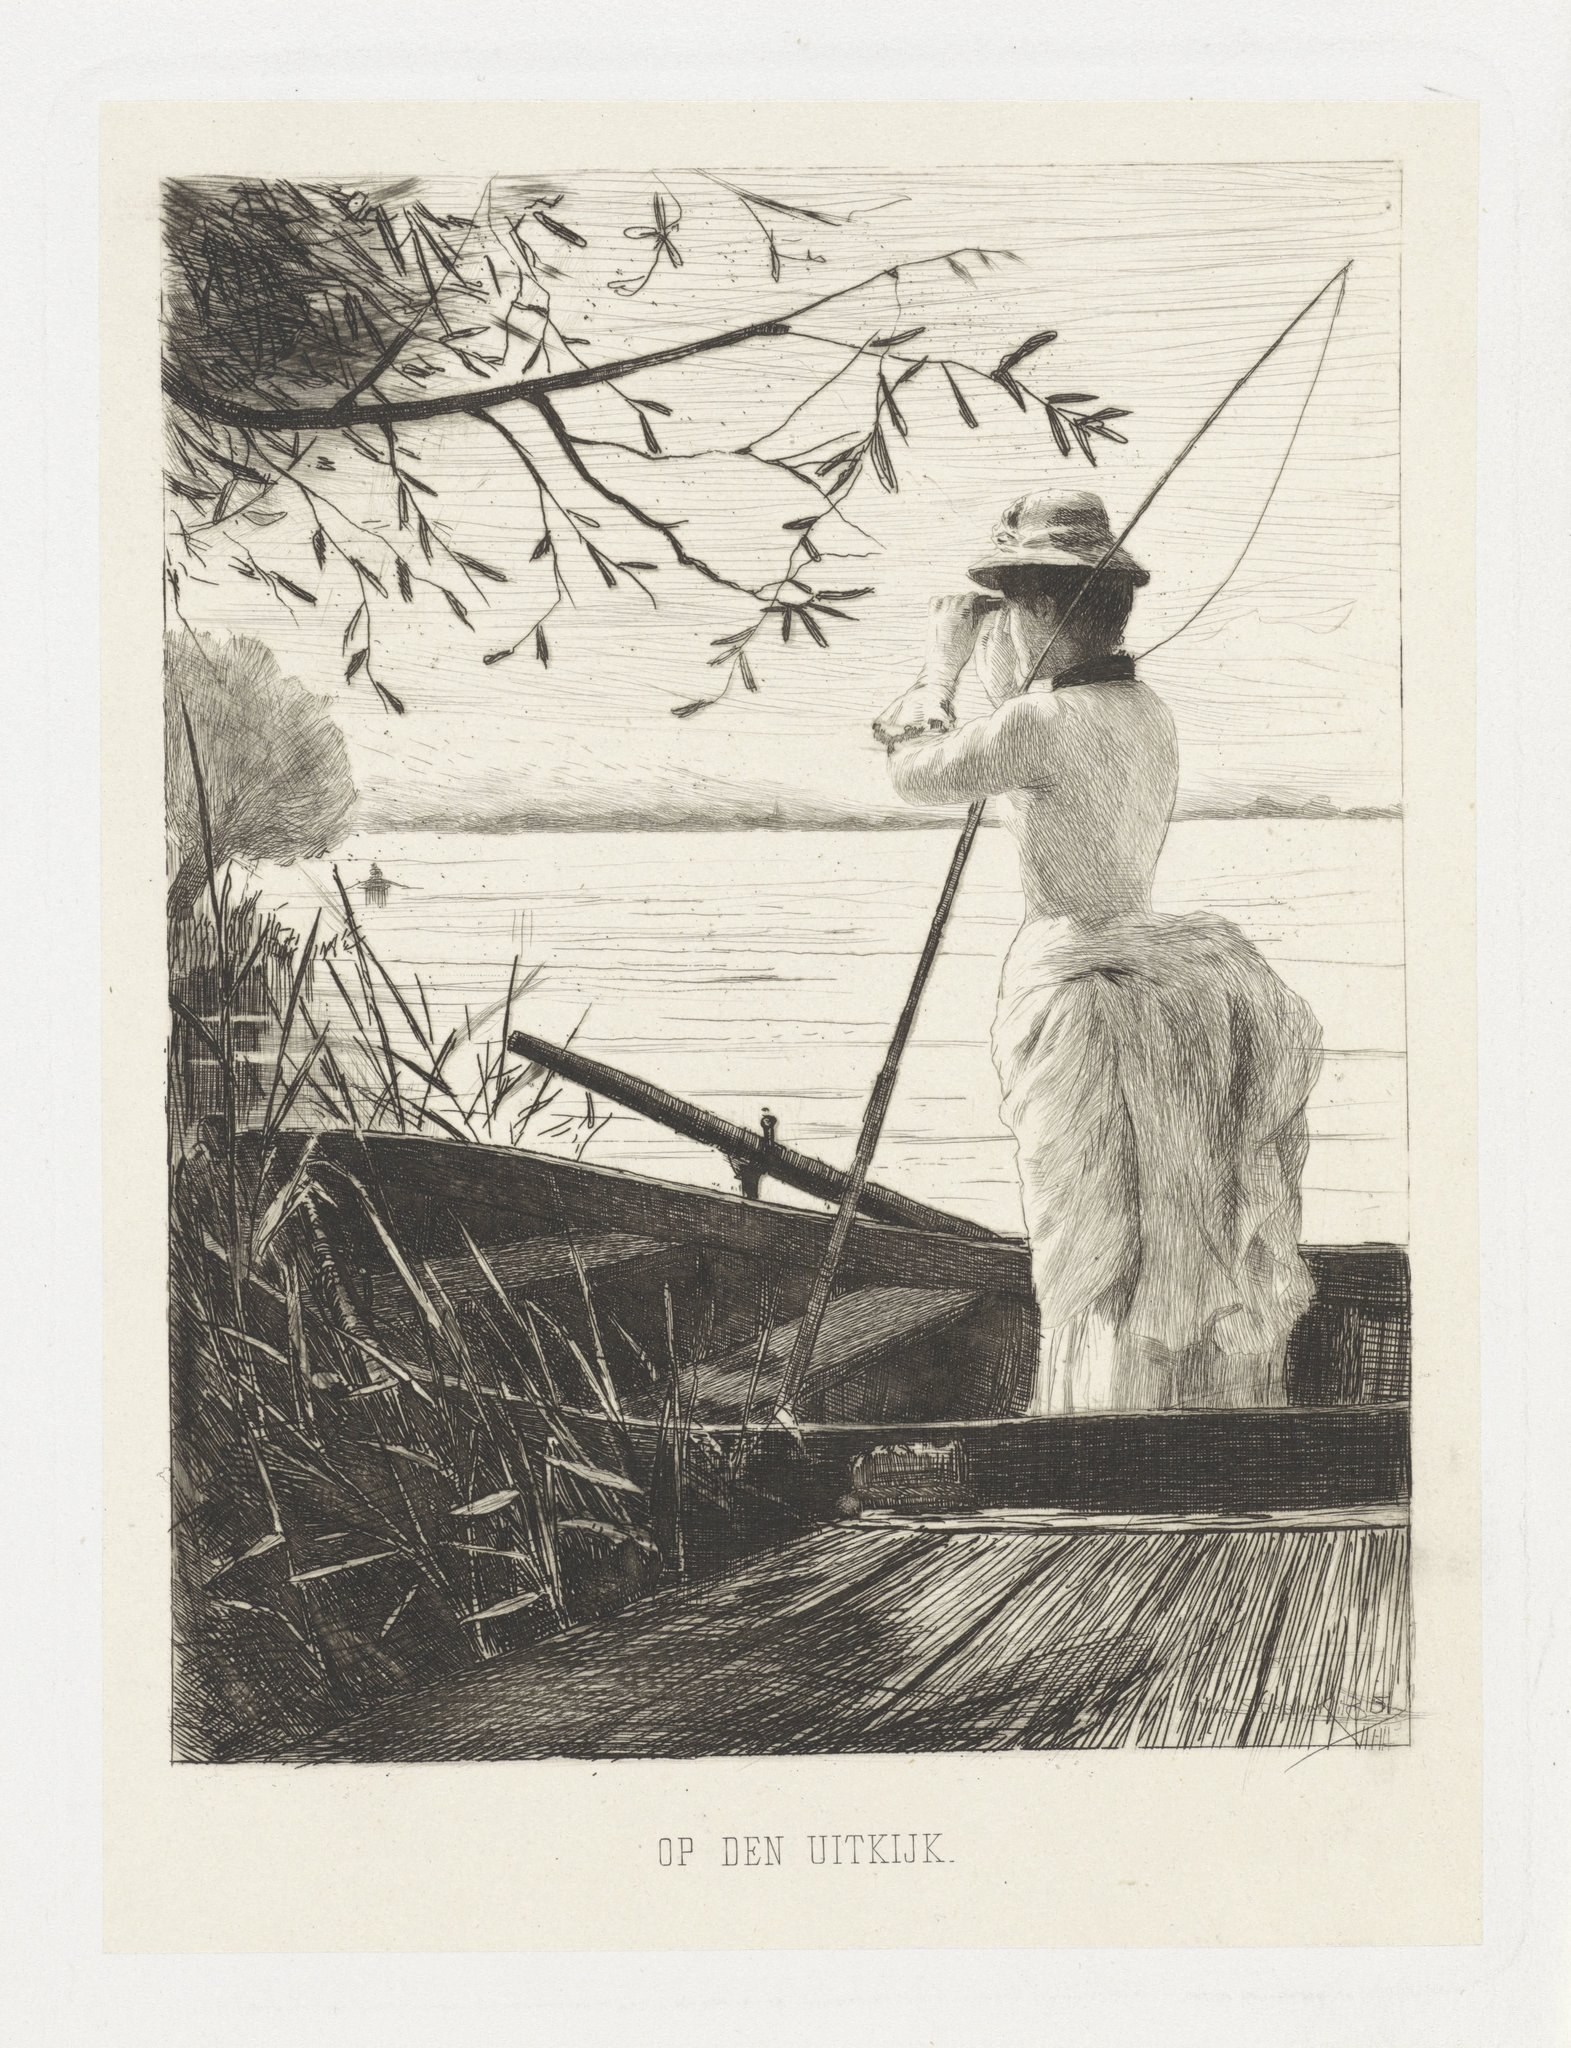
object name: print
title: Op den Uitkijk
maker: willem steelink (ii)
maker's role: draughtsman, print maker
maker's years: 1856-1928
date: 1885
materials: paper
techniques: etching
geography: amsterdam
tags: rowing-boat, canoe, etc., binoculars, spy-glass, etc.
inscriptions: collector's mark: Lugt 2228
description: Een vrouw staat in een roeiboot met een vishengel over de schouder en tuurt door een verrekijker naar een roeiboot.